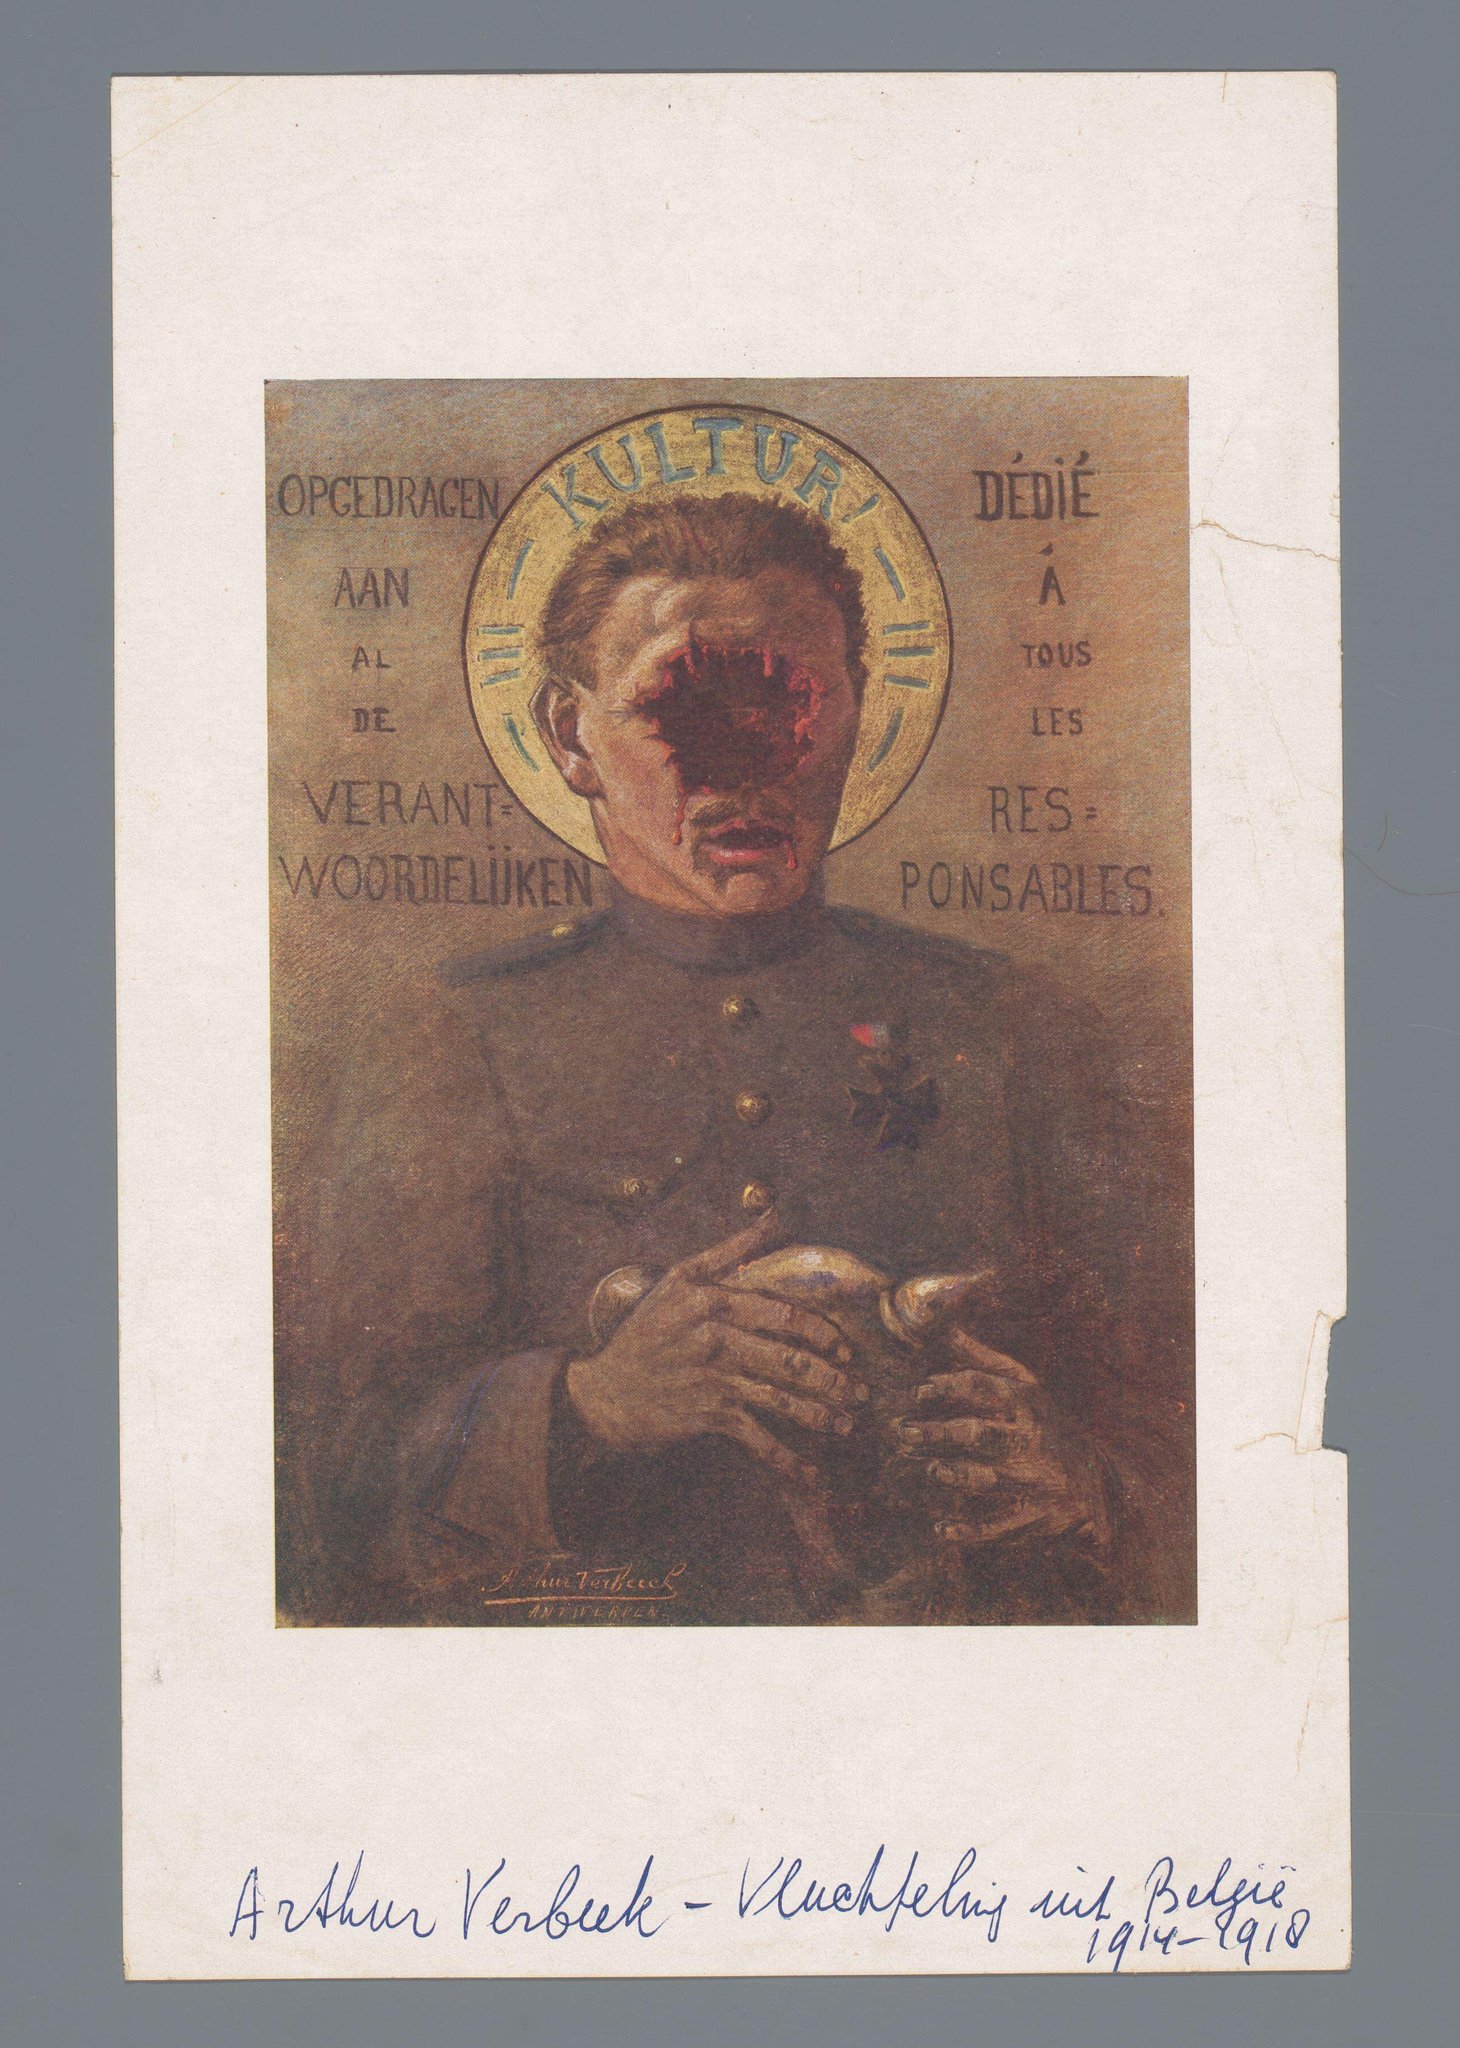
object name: photograph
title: Opgedragen aan al de verantwoordelijken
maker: arthur verbeek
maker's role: fotograaf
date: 1914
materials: paper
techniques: photography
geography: antwerp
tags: netherlands, belgium